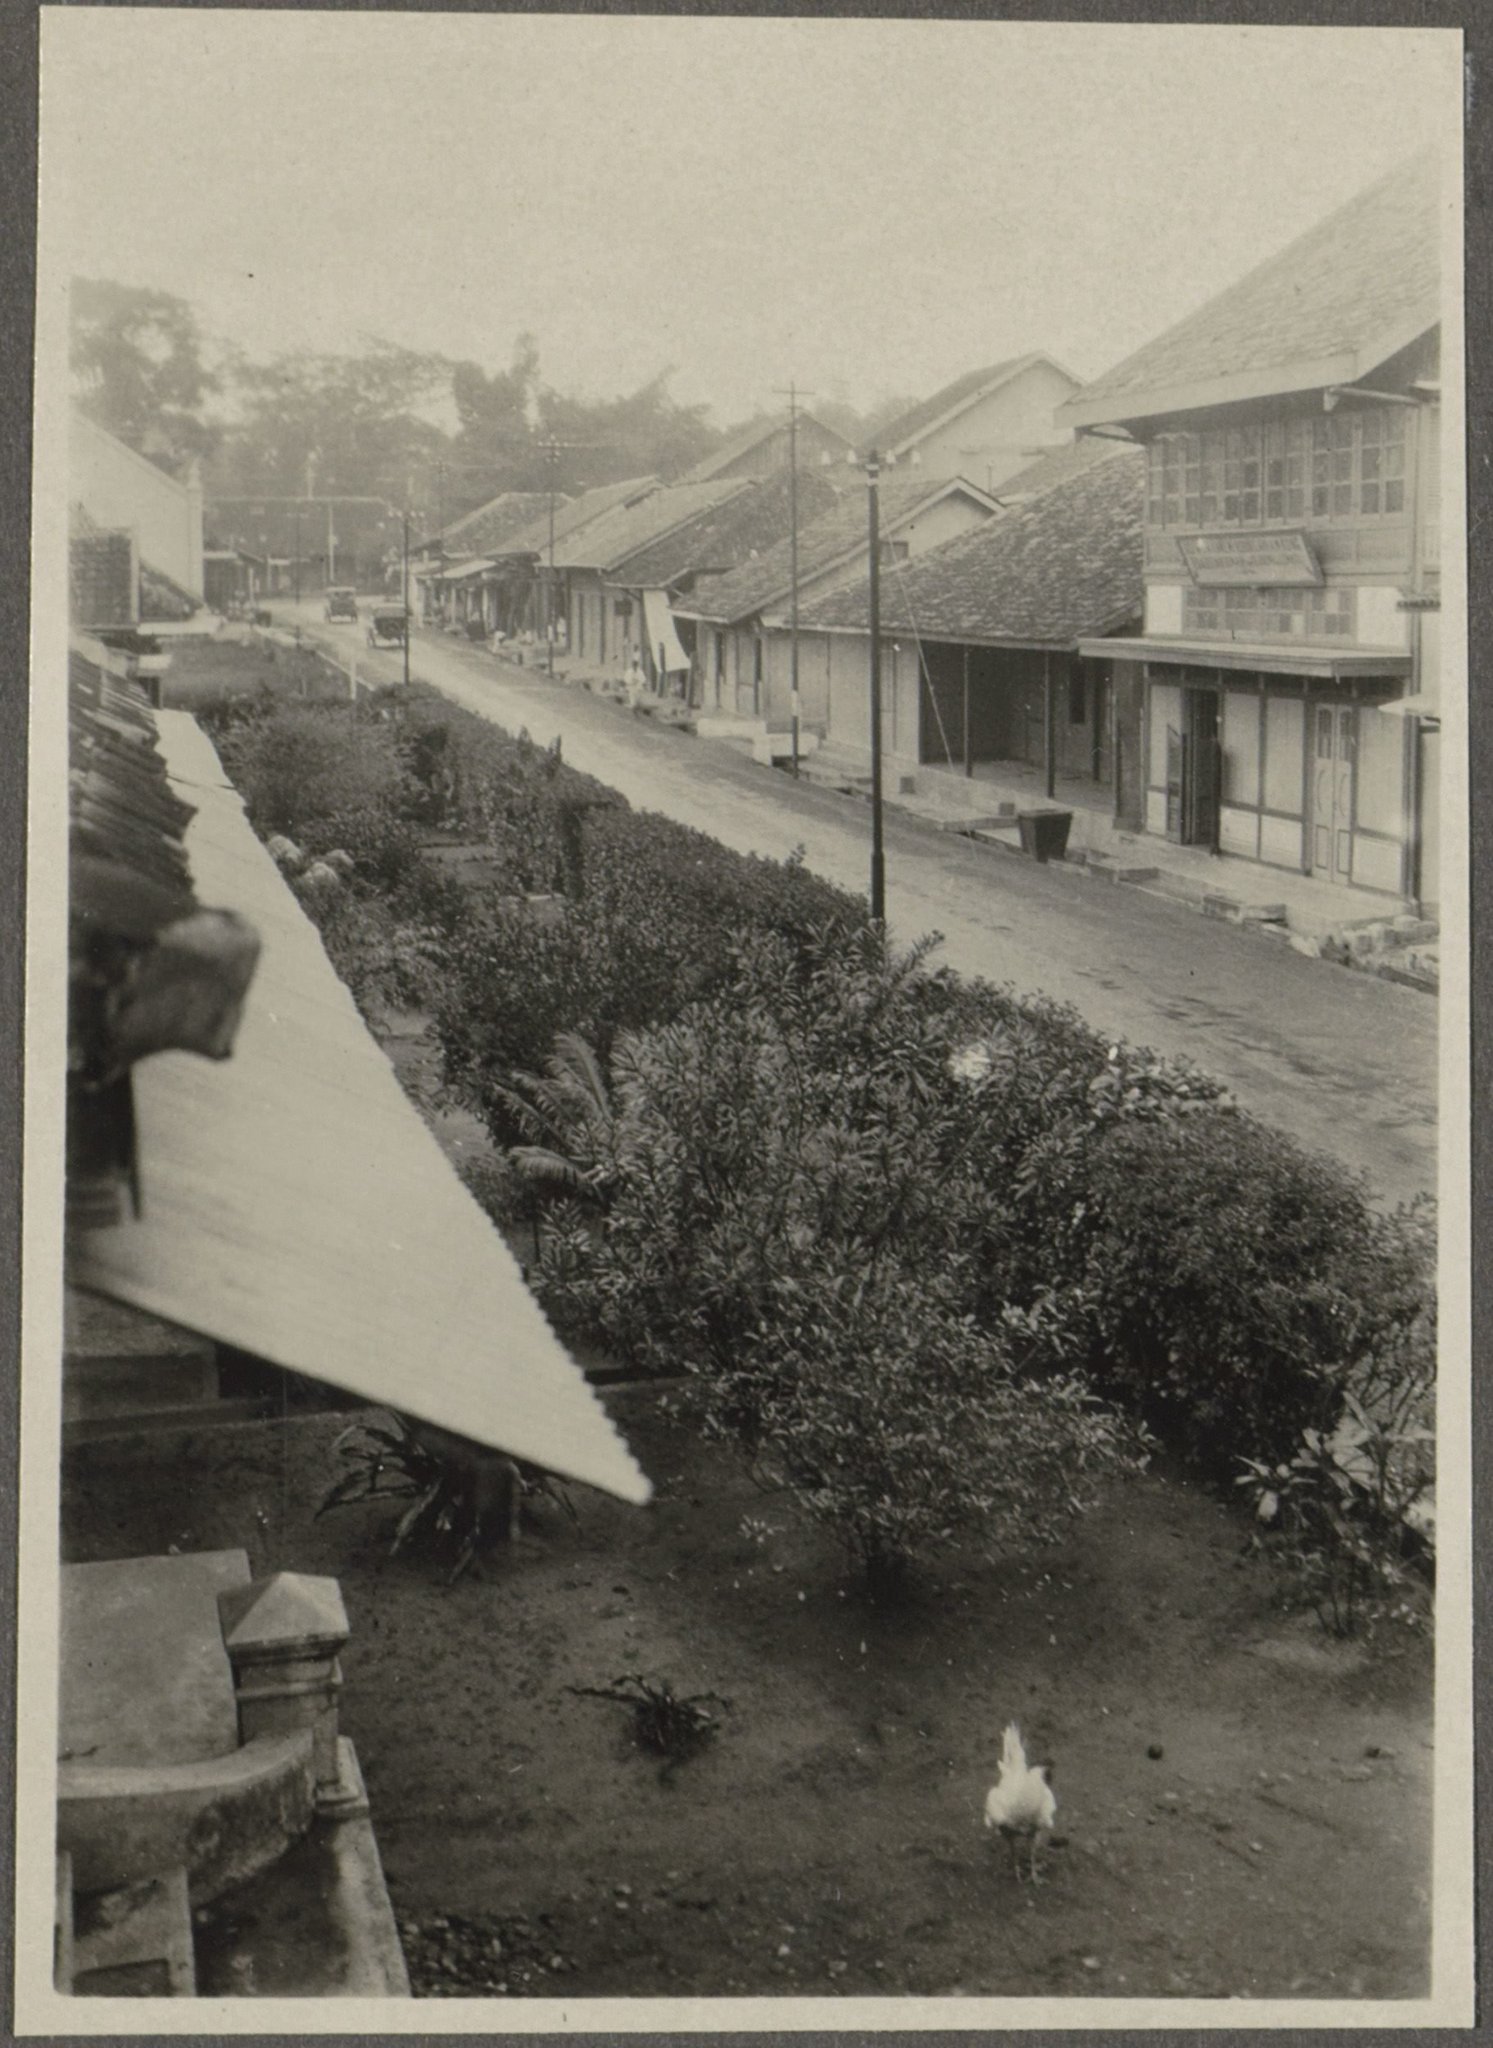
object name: photograph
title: Tandjoengkarang uit de lucht gezien.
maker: Anonymous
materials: photographic support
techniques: gelatin silver print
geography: tandjoeng karang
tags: fowl (cock, hen, chicken, etc.), street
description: Onderdeel van Fotoalbum aangeboden aan de resident der Lampongse districten F.J. Junius door studerende ambtenaren van de bestuursschool te Batavia.